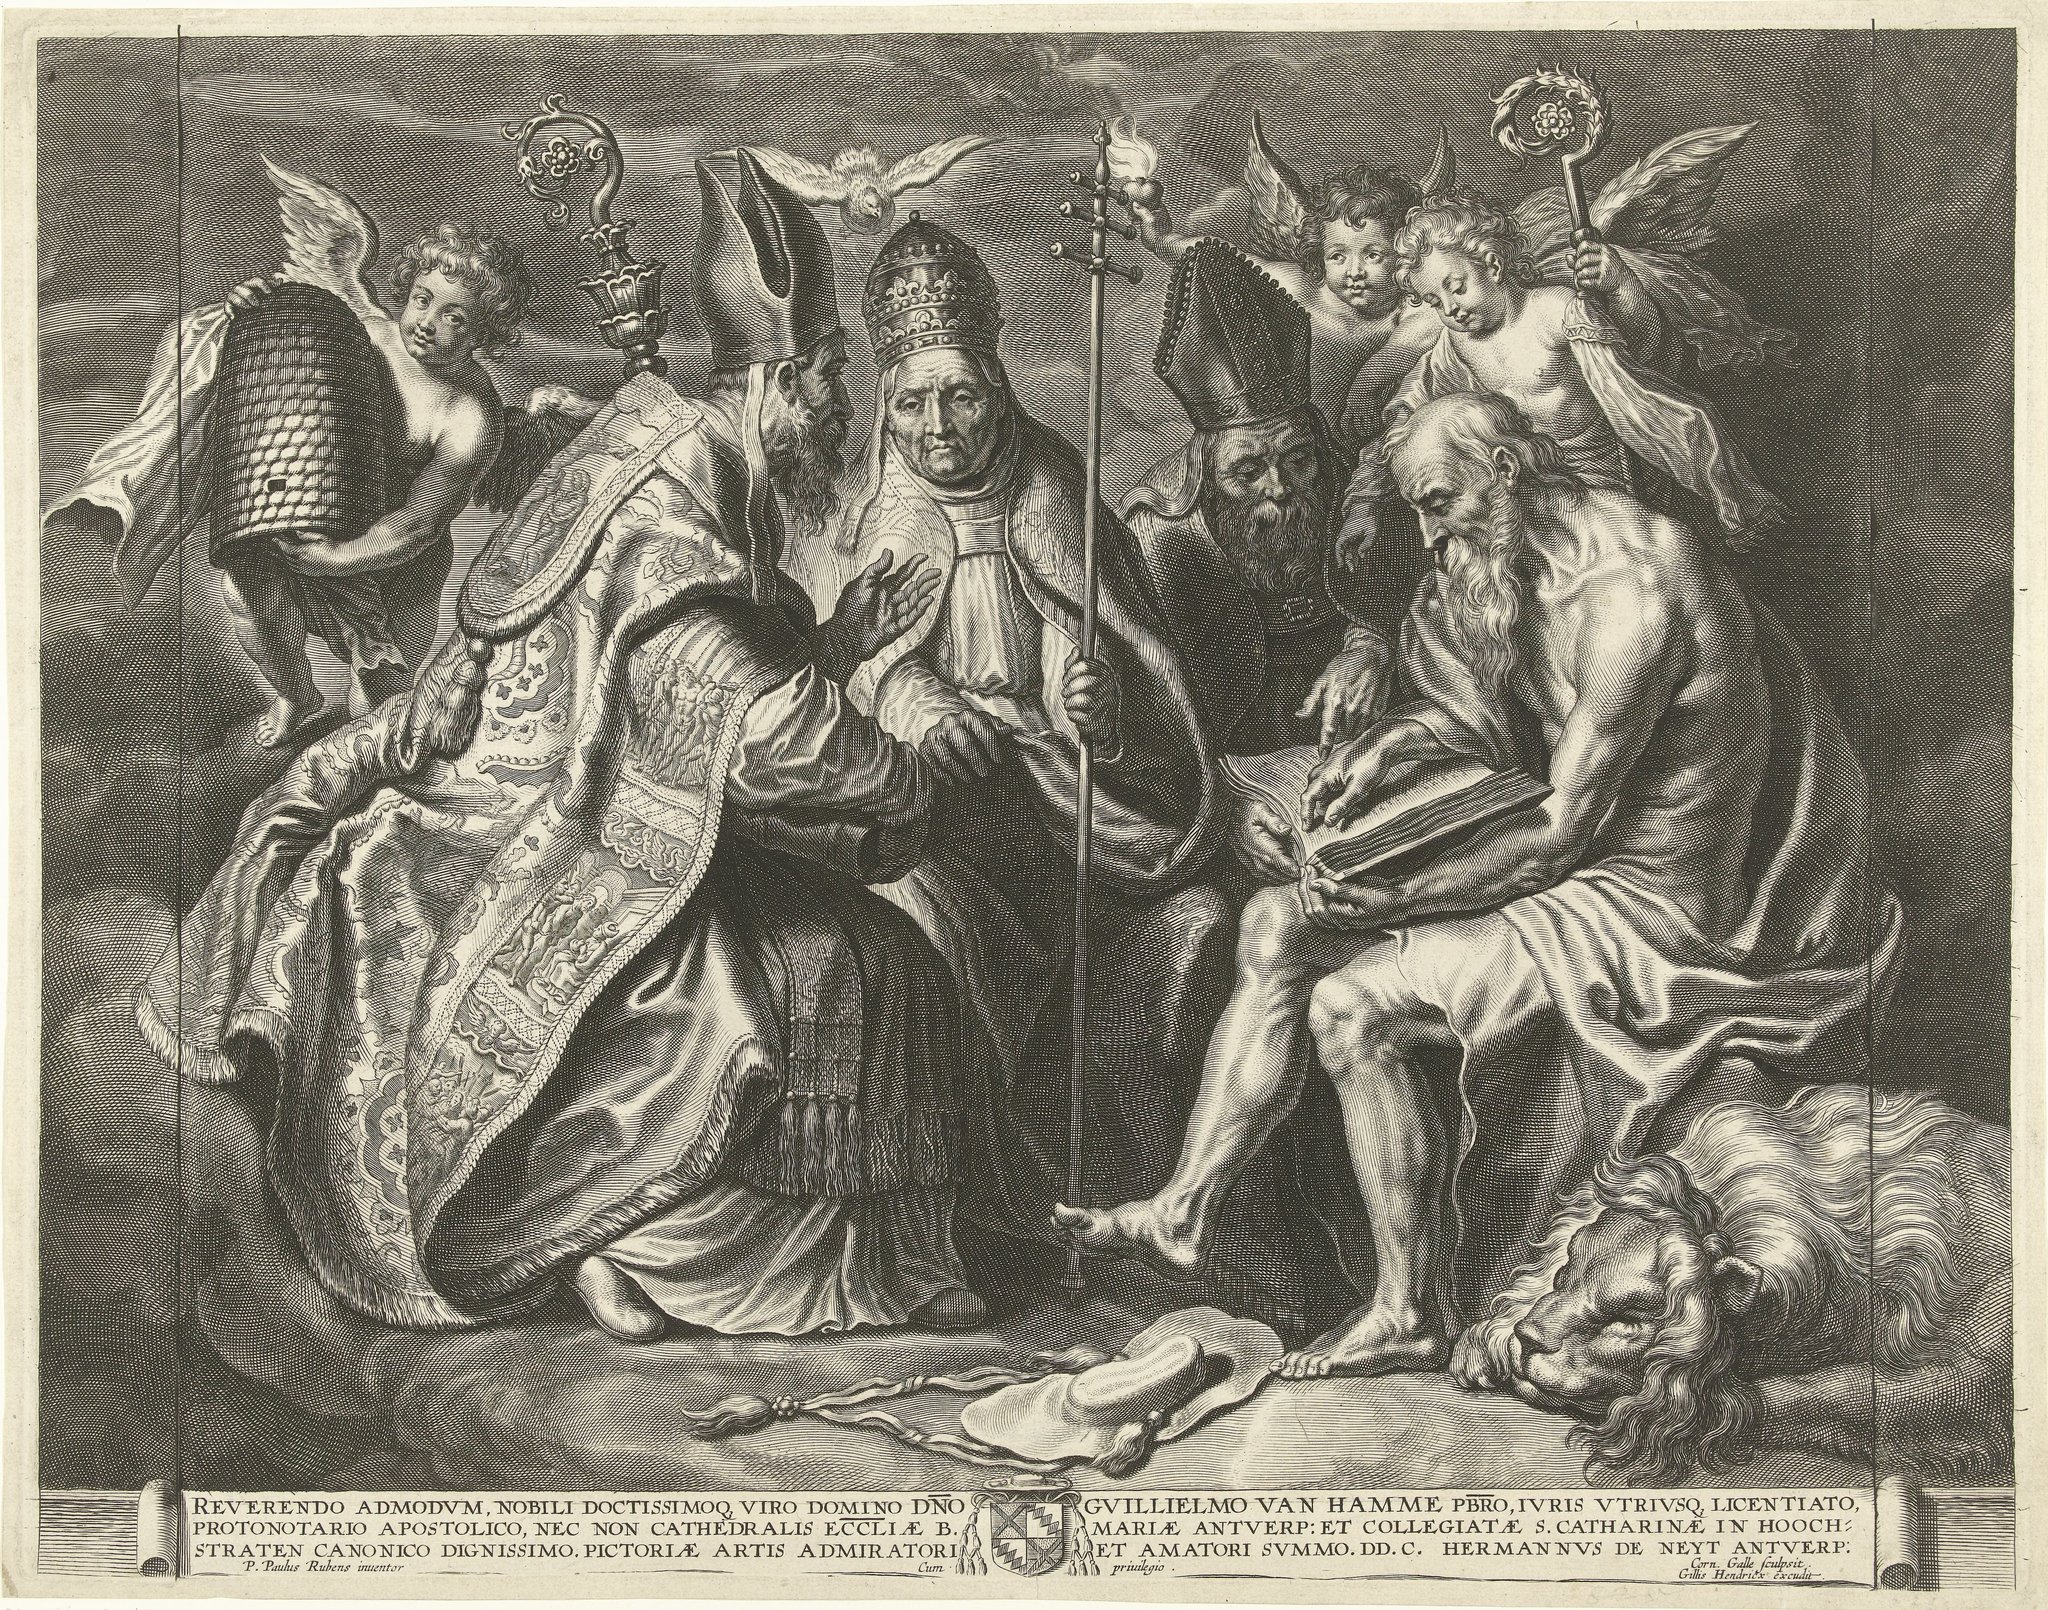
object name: print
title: De vier kerkvaders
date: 1630-1642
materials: paper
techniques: engraving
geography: antwerp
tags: the four latin (western) fathers of the church together: ambrose (usually as bishop), jerome (usually as cardinal), augustine (usually as bishop), gregory the great (usually as pope) (+ angel(s))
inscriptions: collector's mark: Lugt 2228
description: De vier Latijnse kerkvaders zitten in de hemel bij elkaar en bespreken een bijbeltekst. Rechts Hieronymus met de leeuw. Ernaast Augustinus met het brandend hart, in het midden links paus Gregorius en geheel links Ambrosius, te herkennen aan zijn attribuut de bijenkorf.